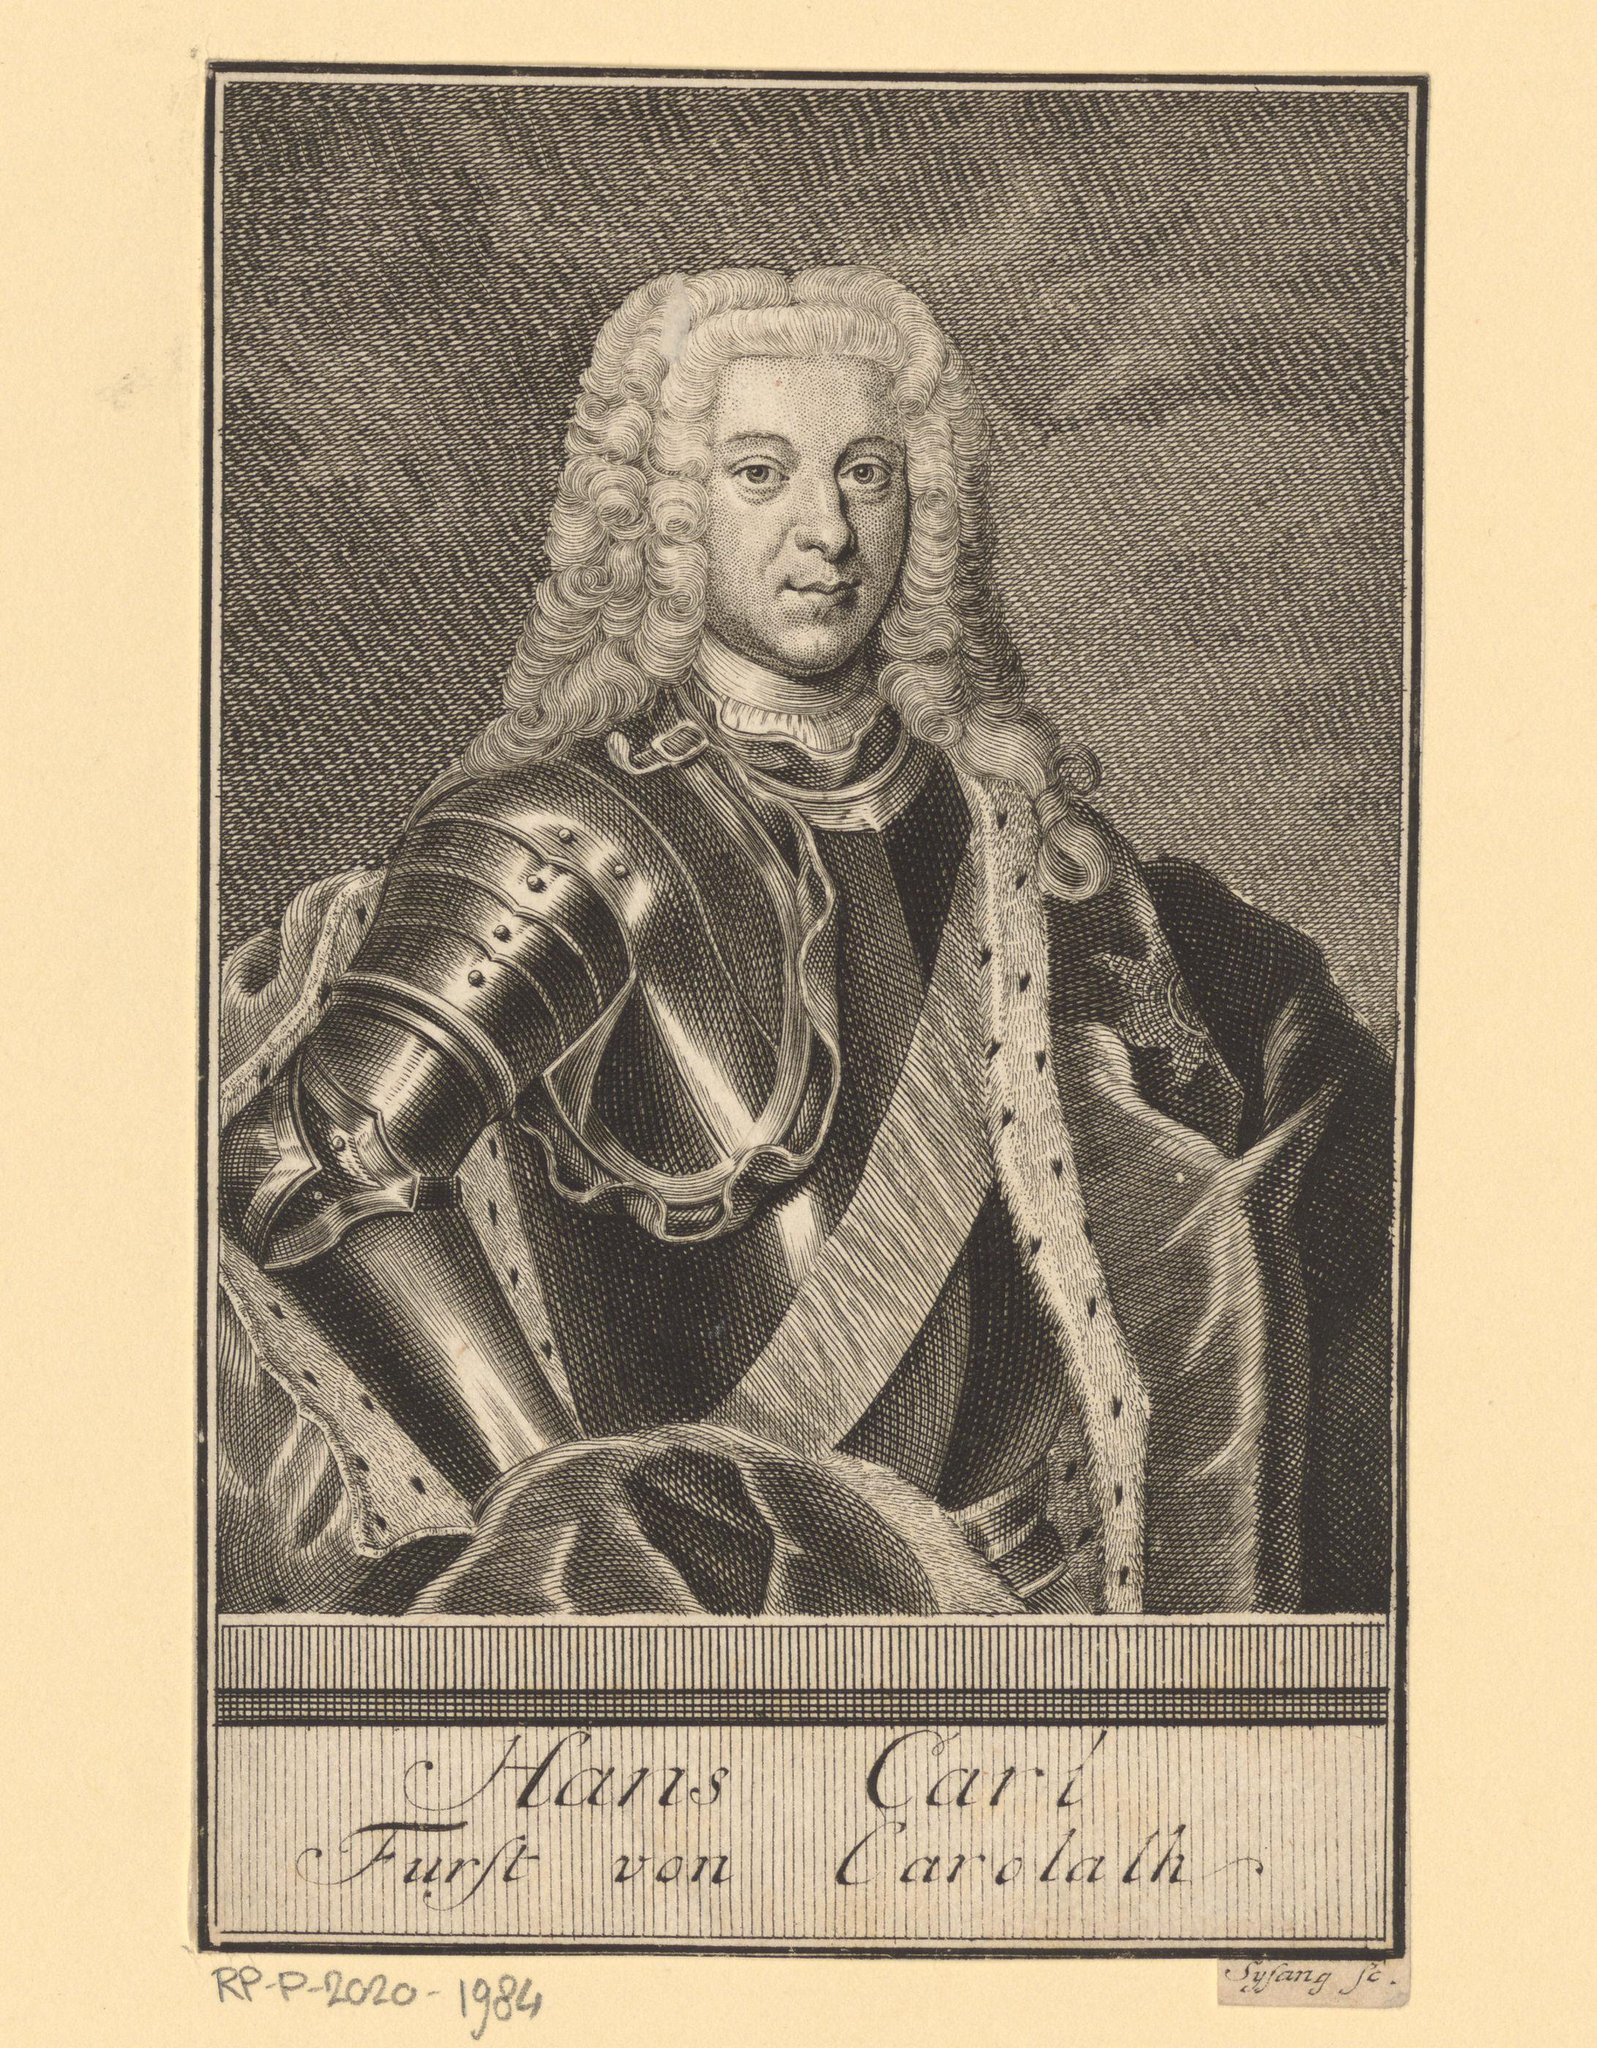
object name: print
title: Portret van Hans Carl Fürst von Carolath-Beuthen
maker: johann christoph sysang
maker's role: print maker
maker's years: 1703-1757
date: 1742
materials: paper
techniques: engraving, etching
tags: poland, historical persons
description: Prent mogelijk uit: Europäischer Staats-Secretarius (...). S.l.s.n., 1742, dl. 81.